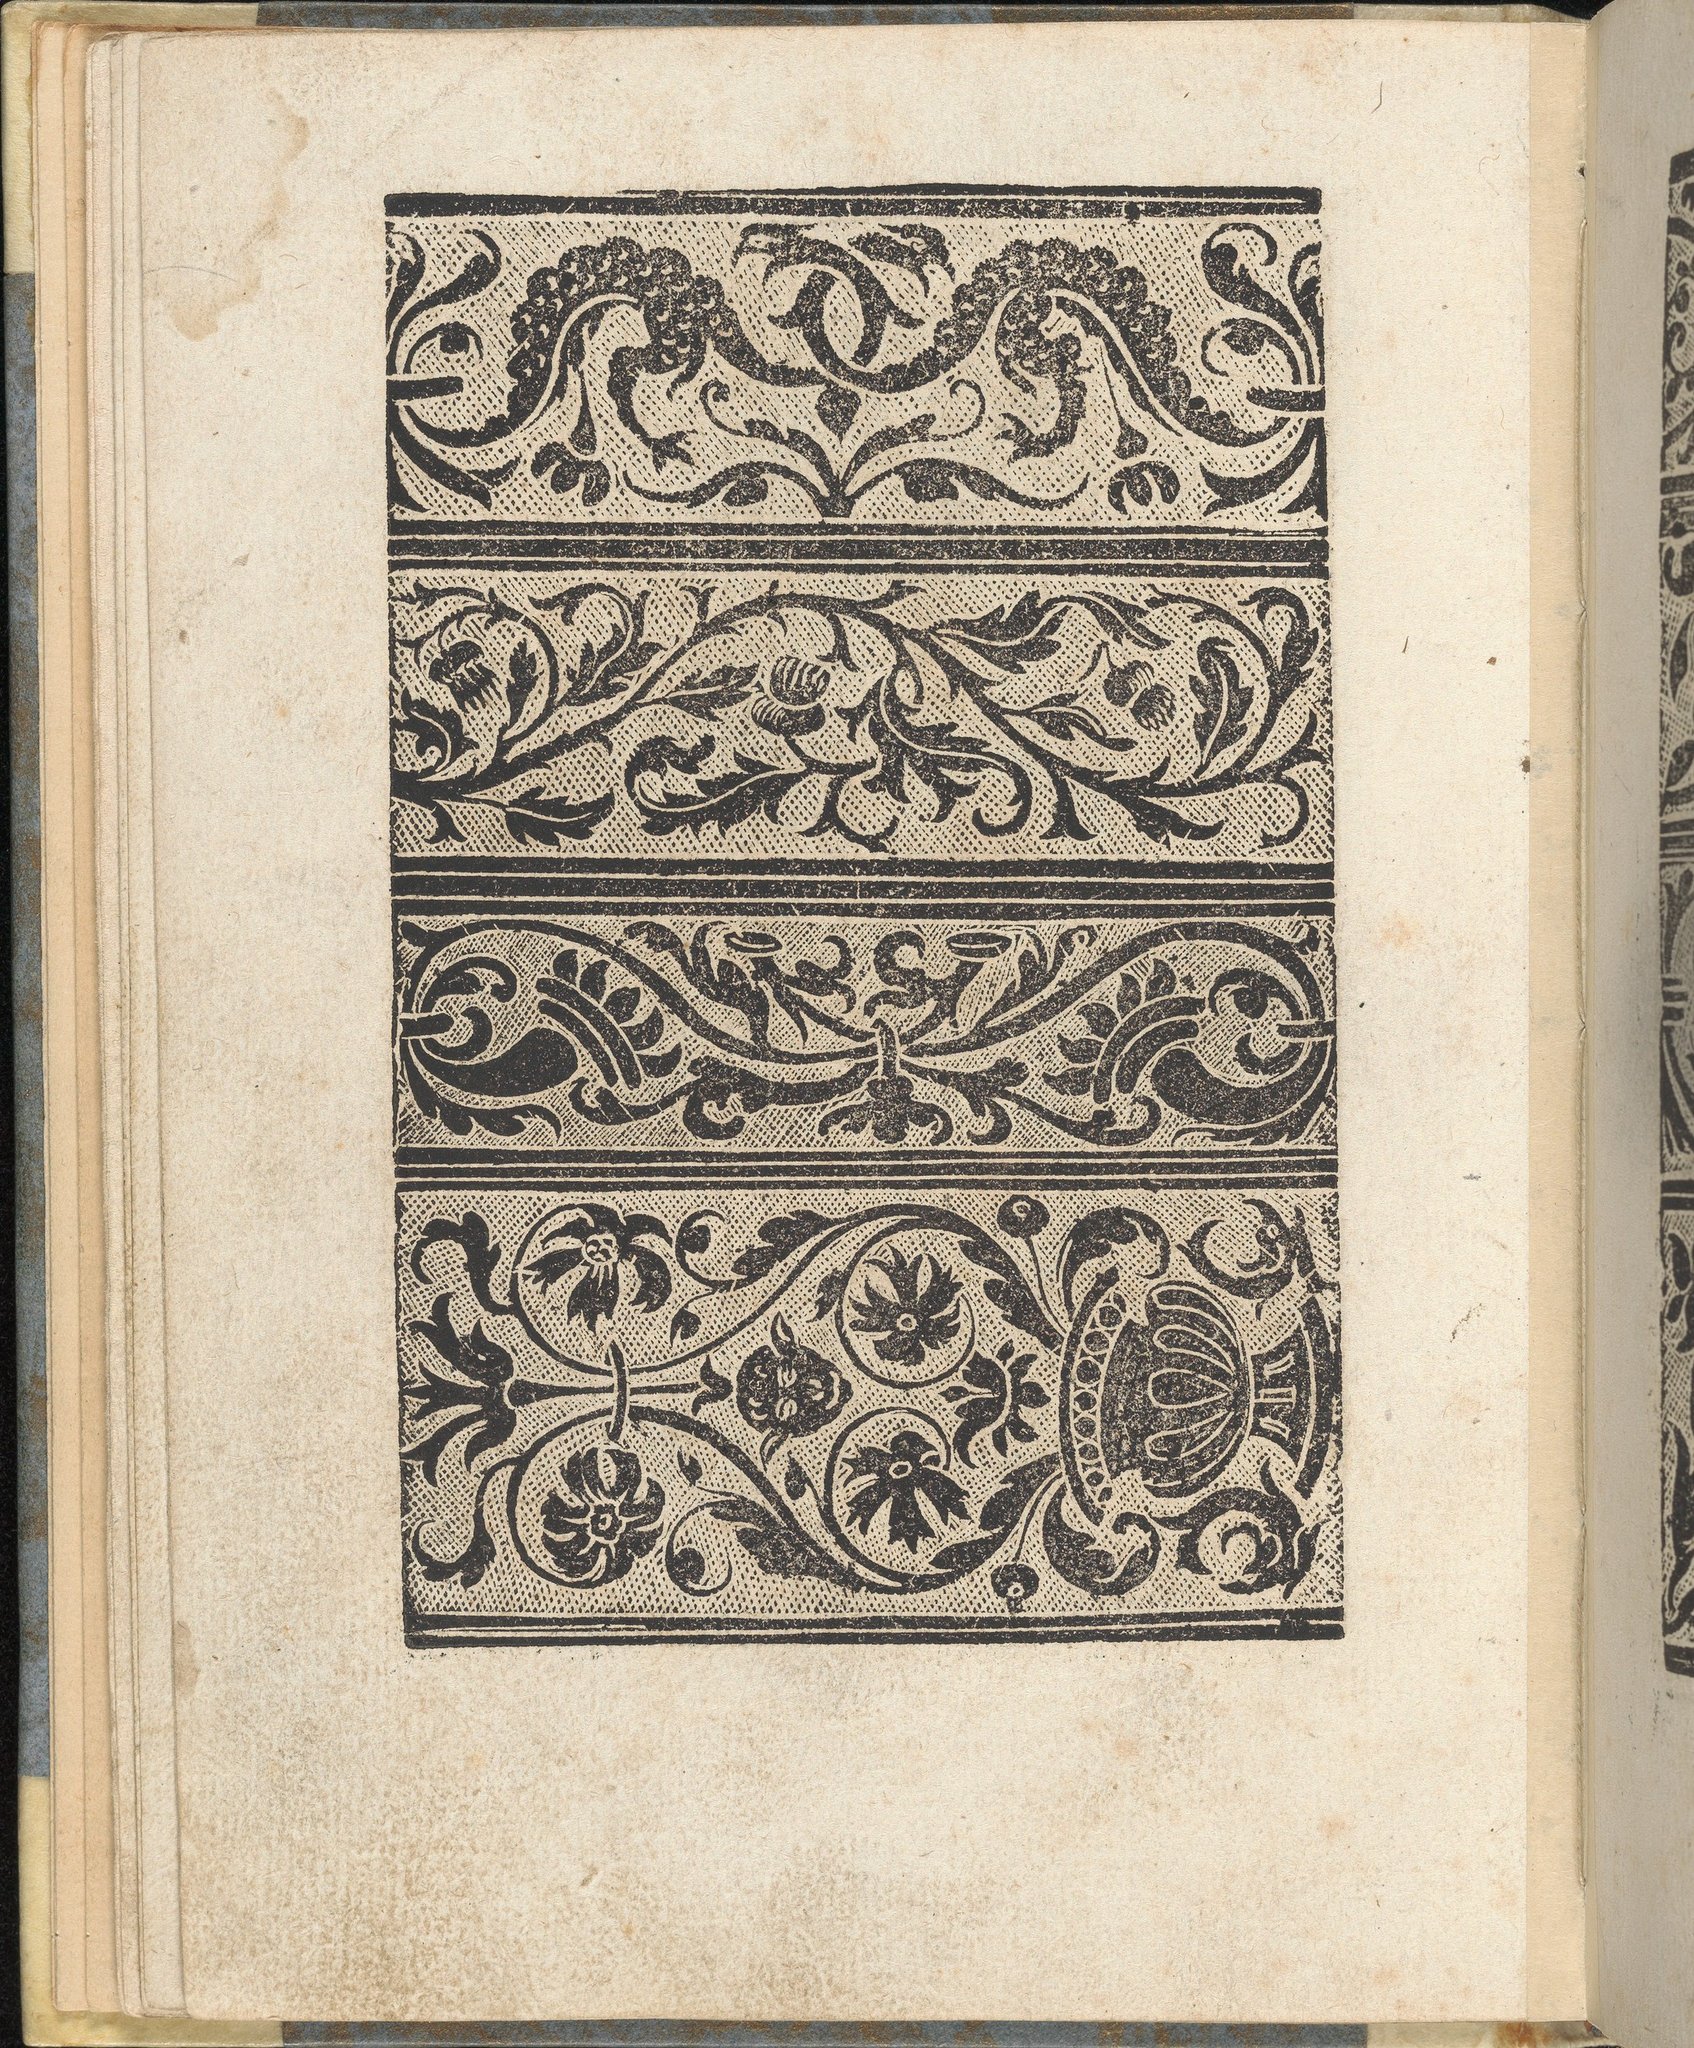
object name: book print ornament architecture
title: Ein ney Furmbüchlein, Page 16, verso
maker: johann schönsperger the younger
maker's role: publisher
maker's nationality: german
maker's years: 1490-1550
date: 1525-1529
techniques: woodcut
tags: flowers